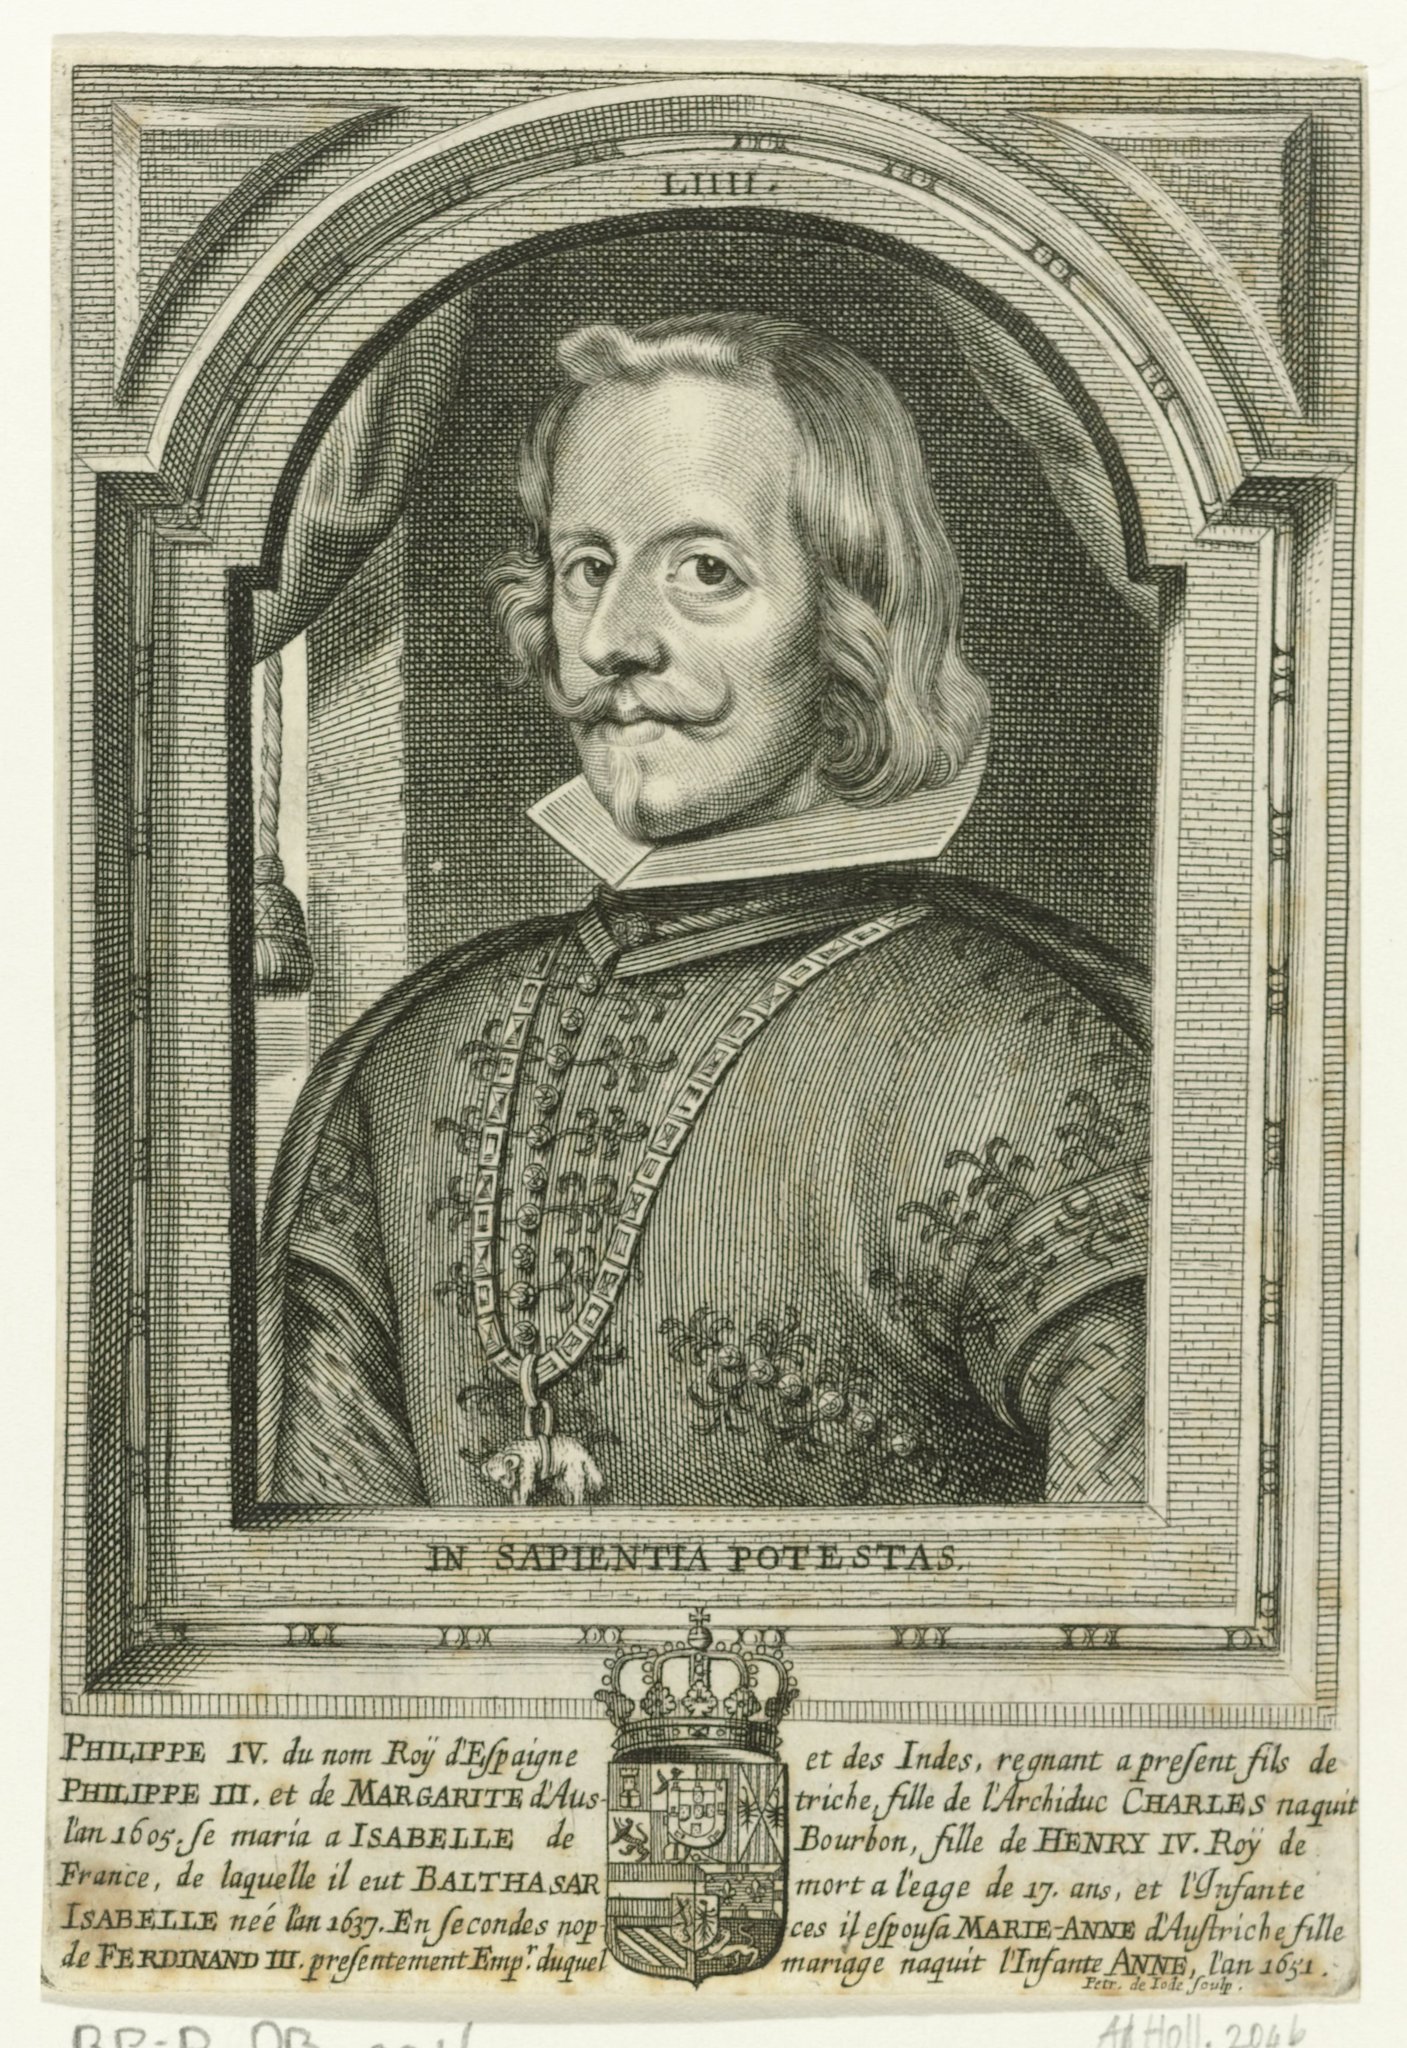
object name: book illustration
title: Portret van Filips IV, koning van Spanje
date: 1661-1663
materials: paper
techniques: engraving, etching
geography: antwerp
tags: filips iv (koning van spanje), knighthood order of the golden fleece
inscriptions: collector's mark: Lugt 240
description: Busteportret van Filips IV, koning van Spanje. Hij draagt een keten met de Orde van het Gulden Vlies. Het portret is gevat in een boogvormige omlijsting met vierkant randwerk en een motto in het Latijn. In de marge het wapenschild van de geportretteerde en een zesregelig onderschrift in het Frans. Prent uit een boek waarin 54 prenten met portretten.